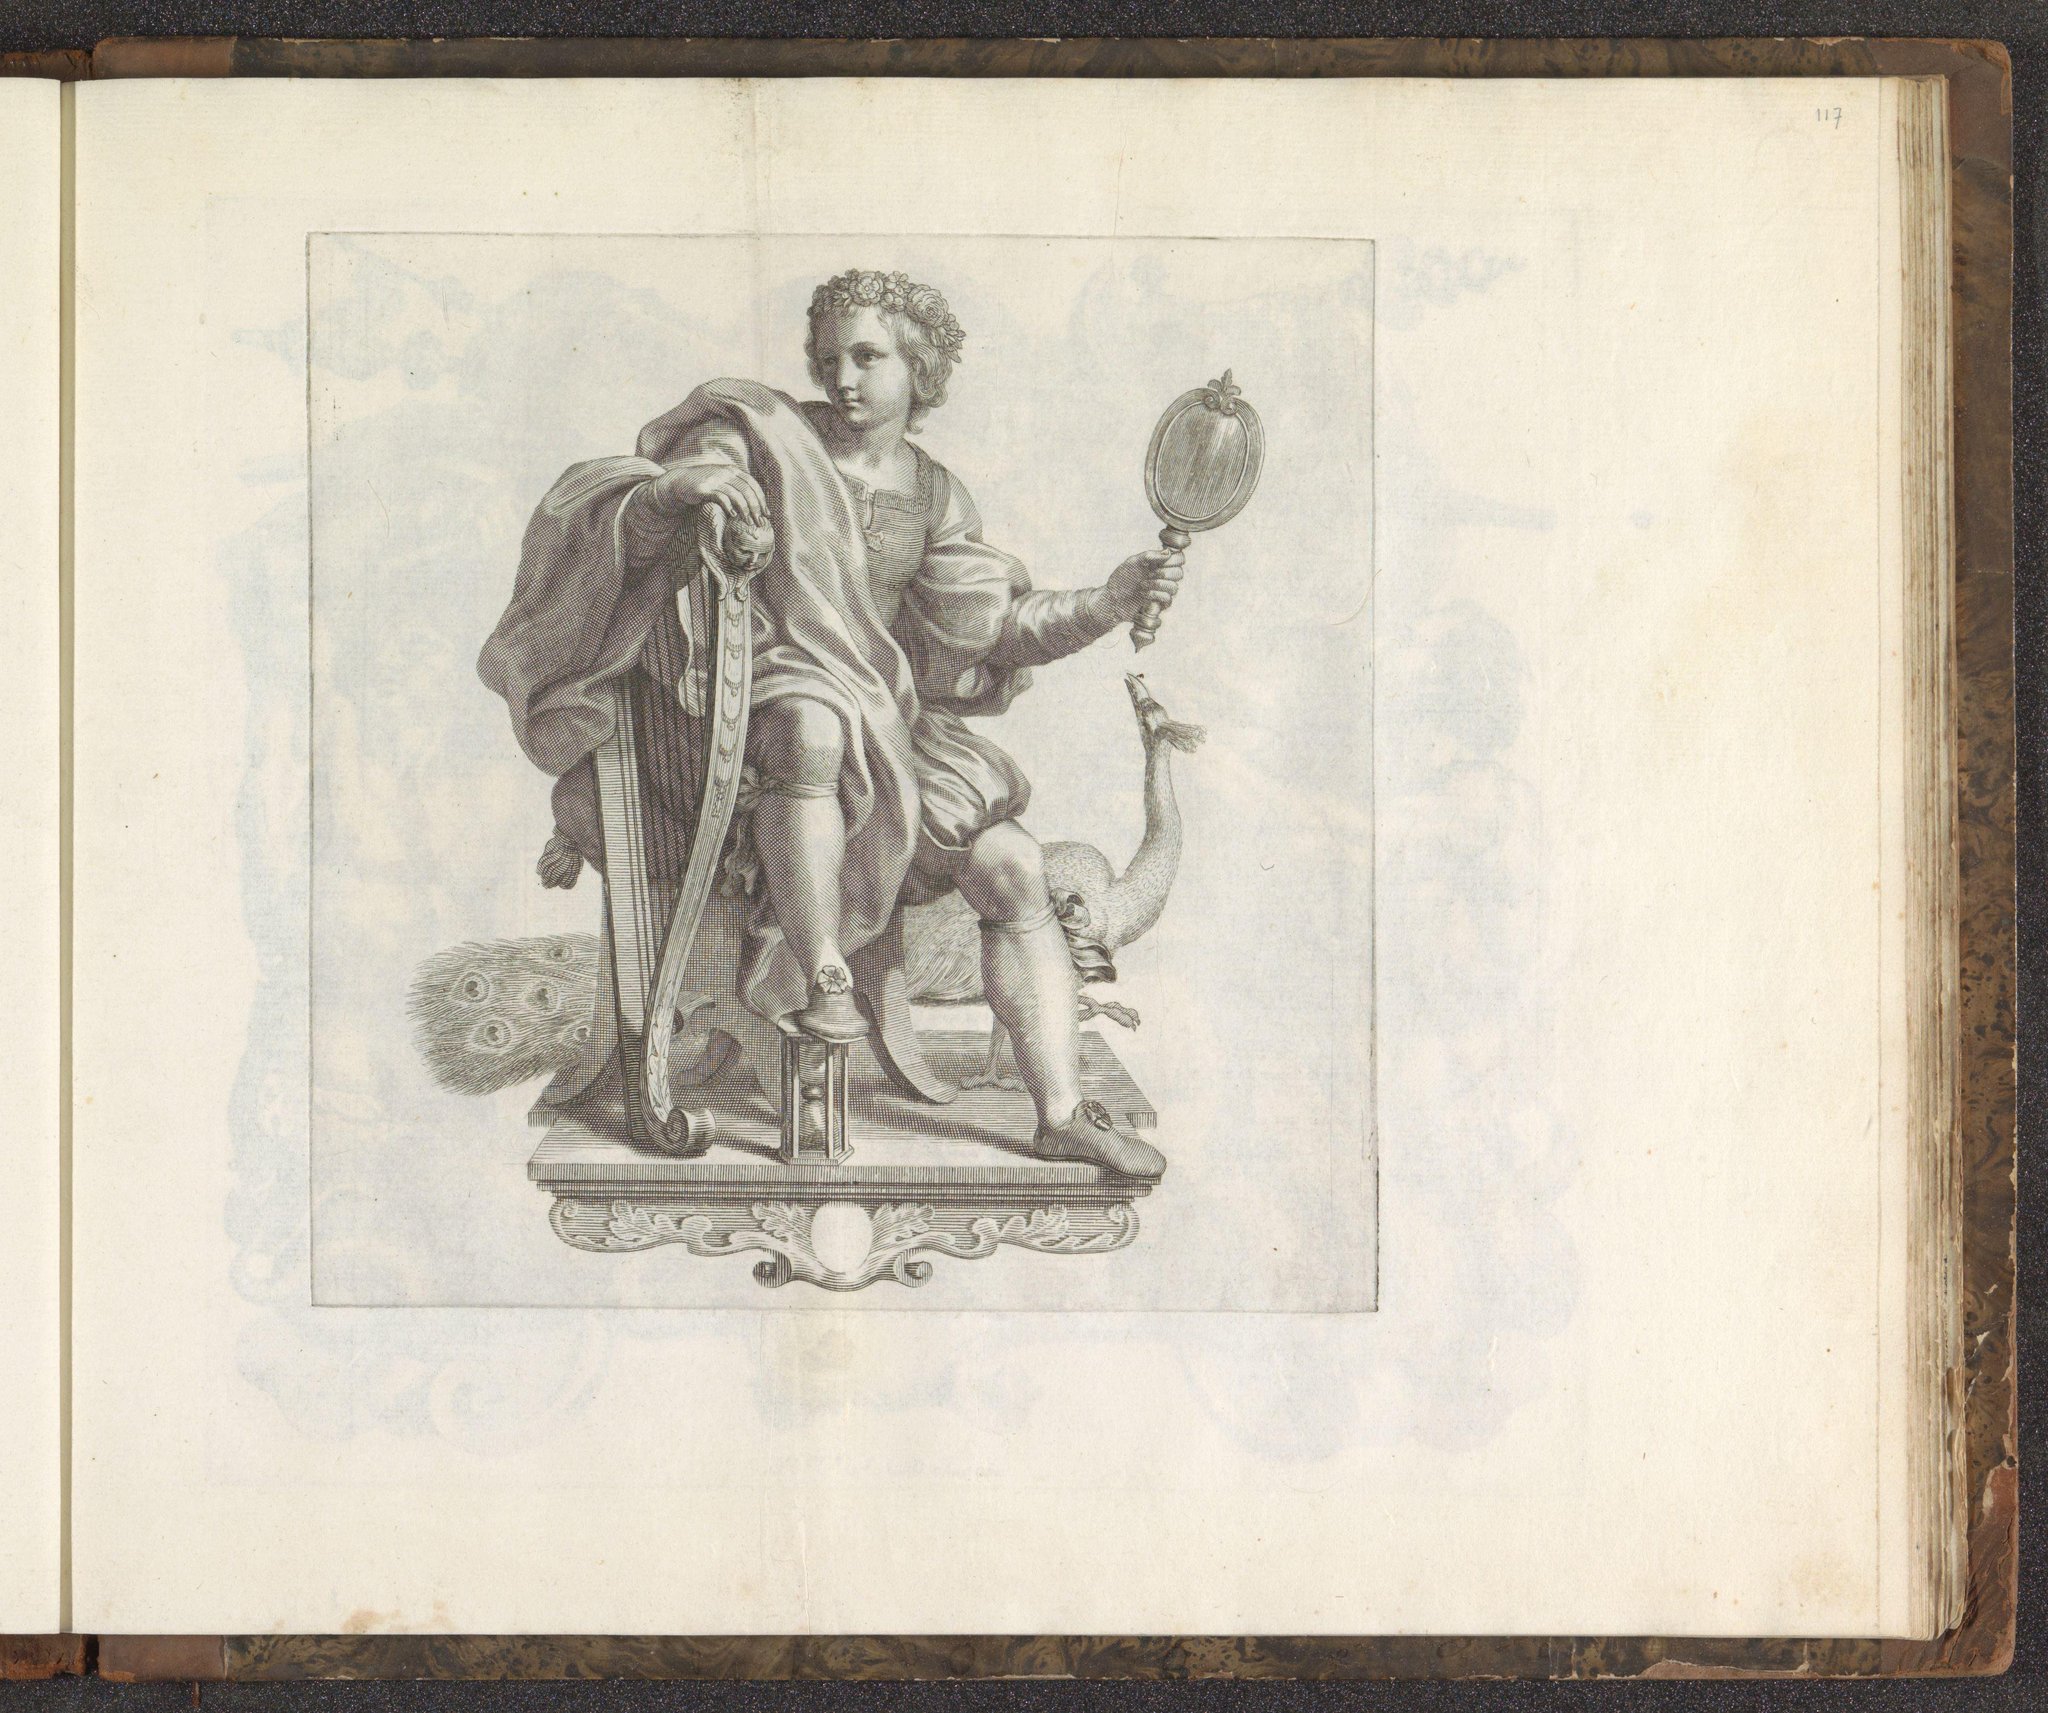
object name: album leaf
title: Personificatie van de Jeugd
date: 1673-1743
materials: paper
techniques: engraving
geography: rome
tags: mirror, ornamental birds: peacock, harp, hourglass, youth, adolescence, 'iuventus'; 'adolescenza', 'gioventù' (ripa)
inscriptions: collector's mark: Lugt 2228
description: Een console met een jongeman, gekroond met bloemenkrans. Zijn rechterhand ligt op een harp. In zijn linkerhand heeft hij een spiegel. Zijn voet leunt op een zandloper en achter hem staat een pauw. De prent maakt deel uit van een album.